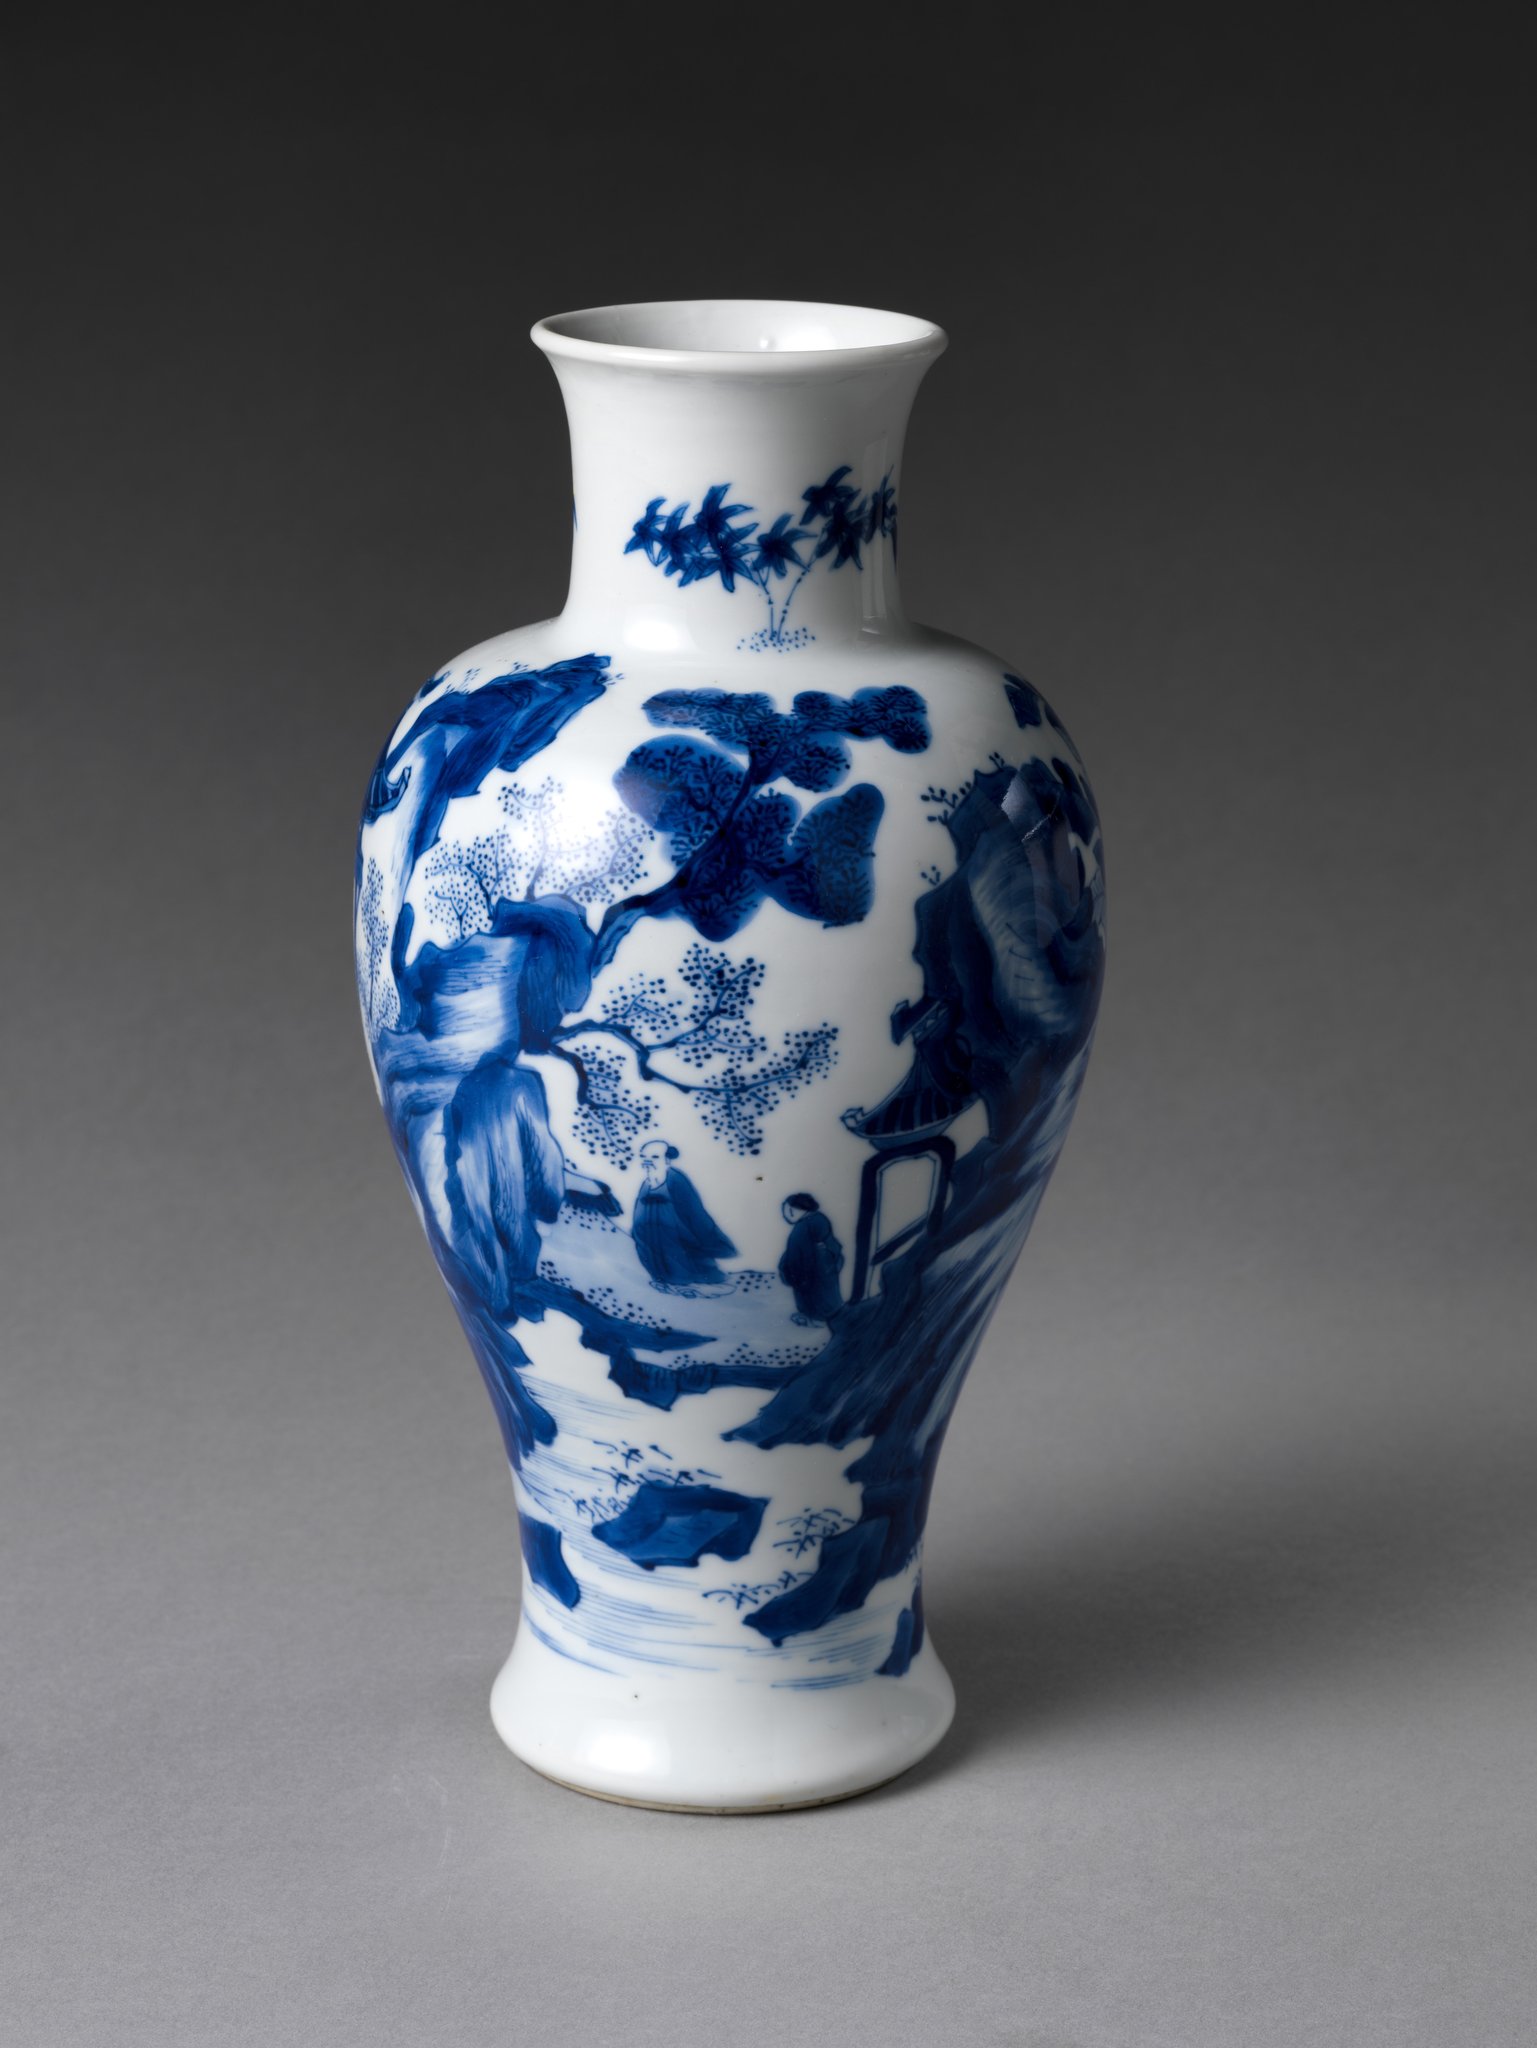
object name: vase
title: Vase with Scholars in Landscape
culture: chinese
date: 1667-1700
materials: cobalt, glaze, porcelain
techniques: painting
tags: human figures